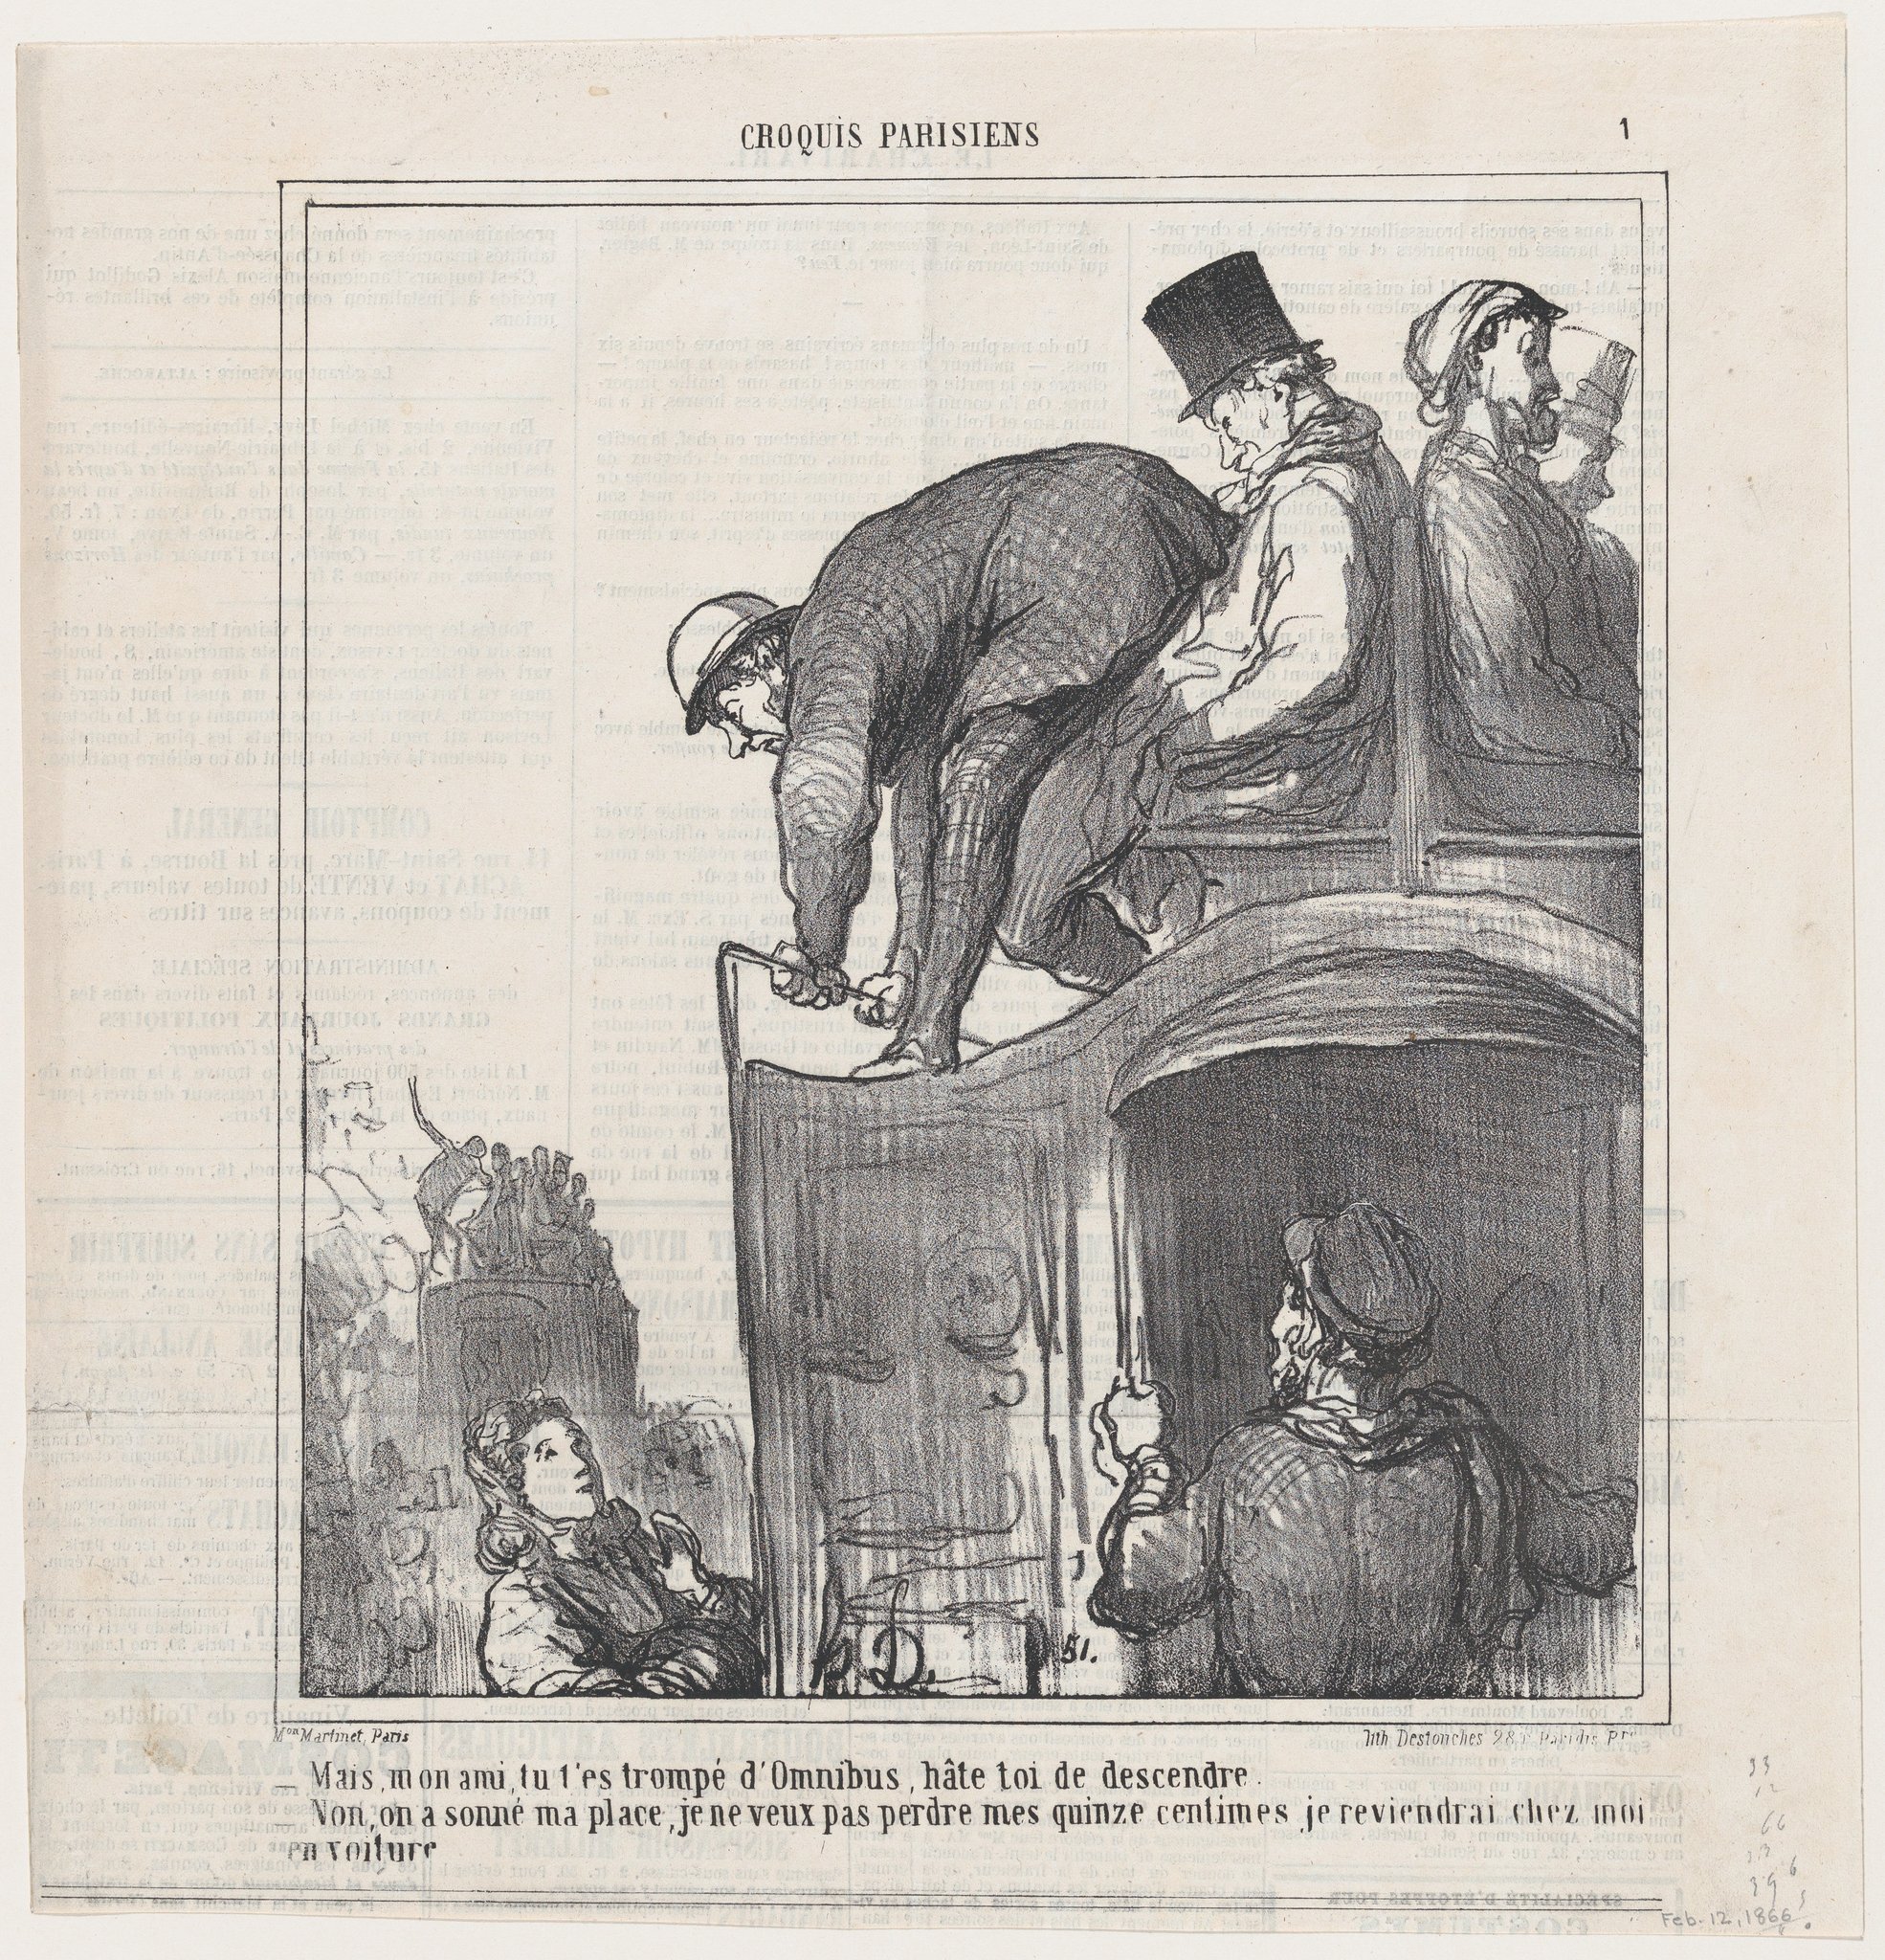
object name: print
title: My friend, you have taken the wrong bus, get out quickly!, from 'Parisian sketches,' published in Le Charivari, February 12, 1866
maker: honoré daumier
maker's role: artist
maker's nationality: french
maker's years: 1808-1879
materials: paper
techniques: lithograph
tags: men,women,buses